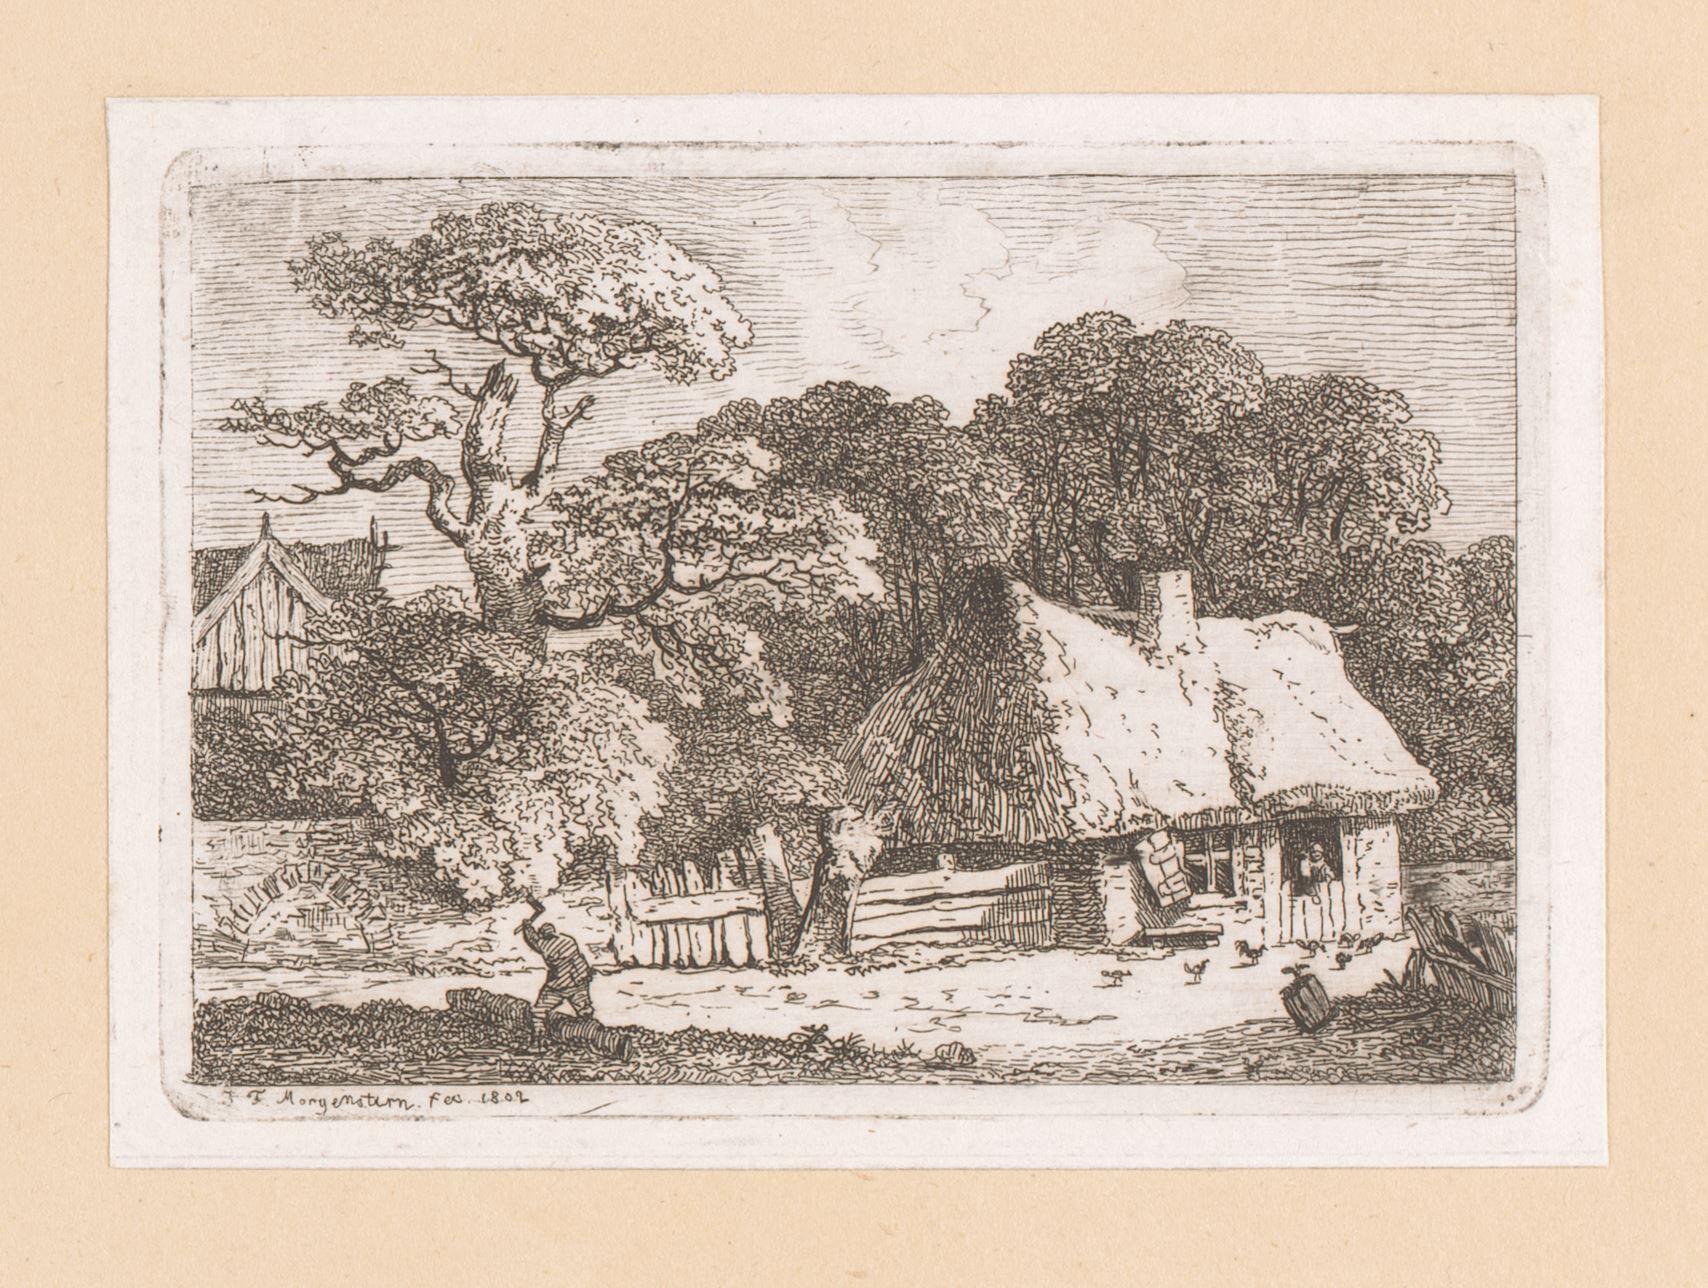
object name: print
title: Dorpsgezicht met houthakker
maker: johann friedrich morgenstern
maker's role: print maker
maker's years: 1777-1844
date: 1802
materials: paper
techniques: etching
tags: woodcutting, woodcutter ~ forestry, village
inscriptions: collector's mark: Lugt 2228